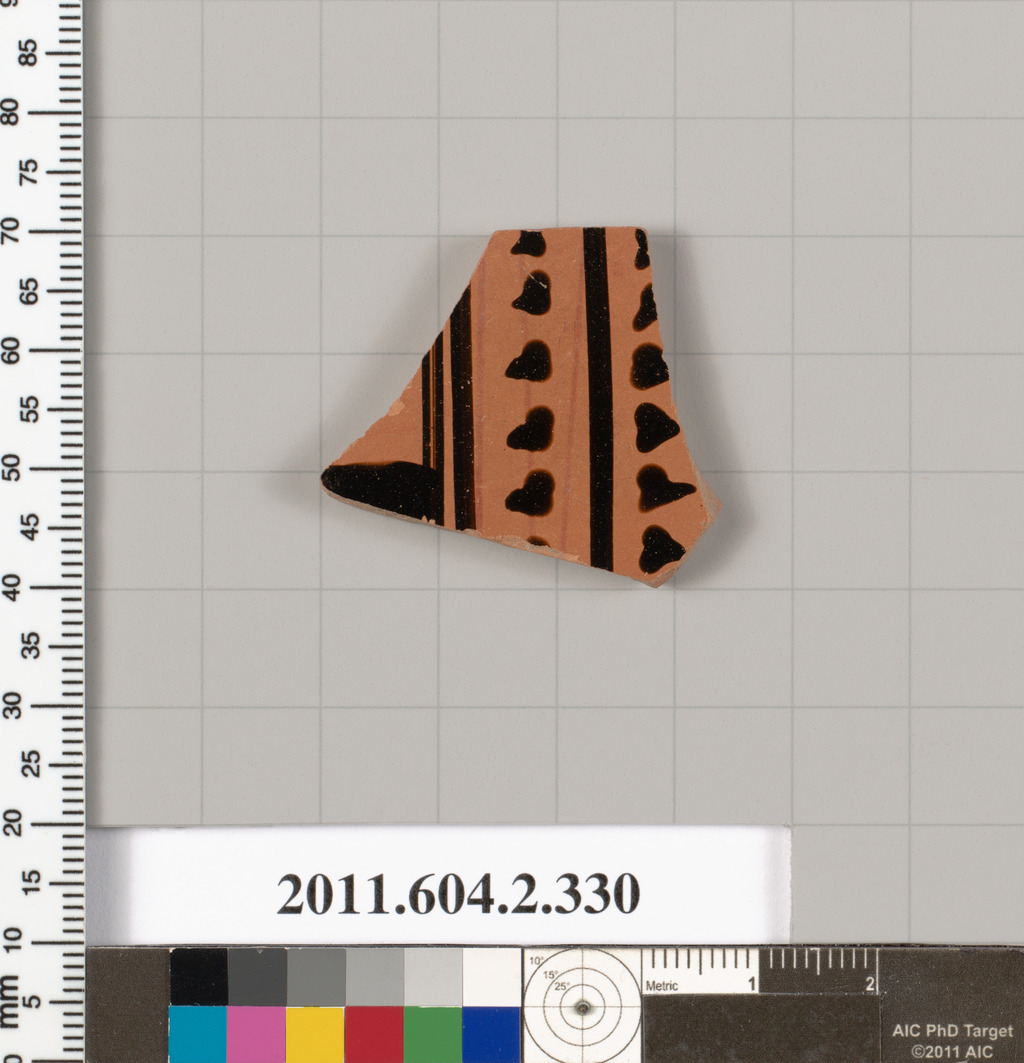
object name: column krater fragment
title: Terracotta fragment of a column-krater (bowl for mixing wine and water)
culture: greek, attic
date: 450-440 BCE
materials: terracotta